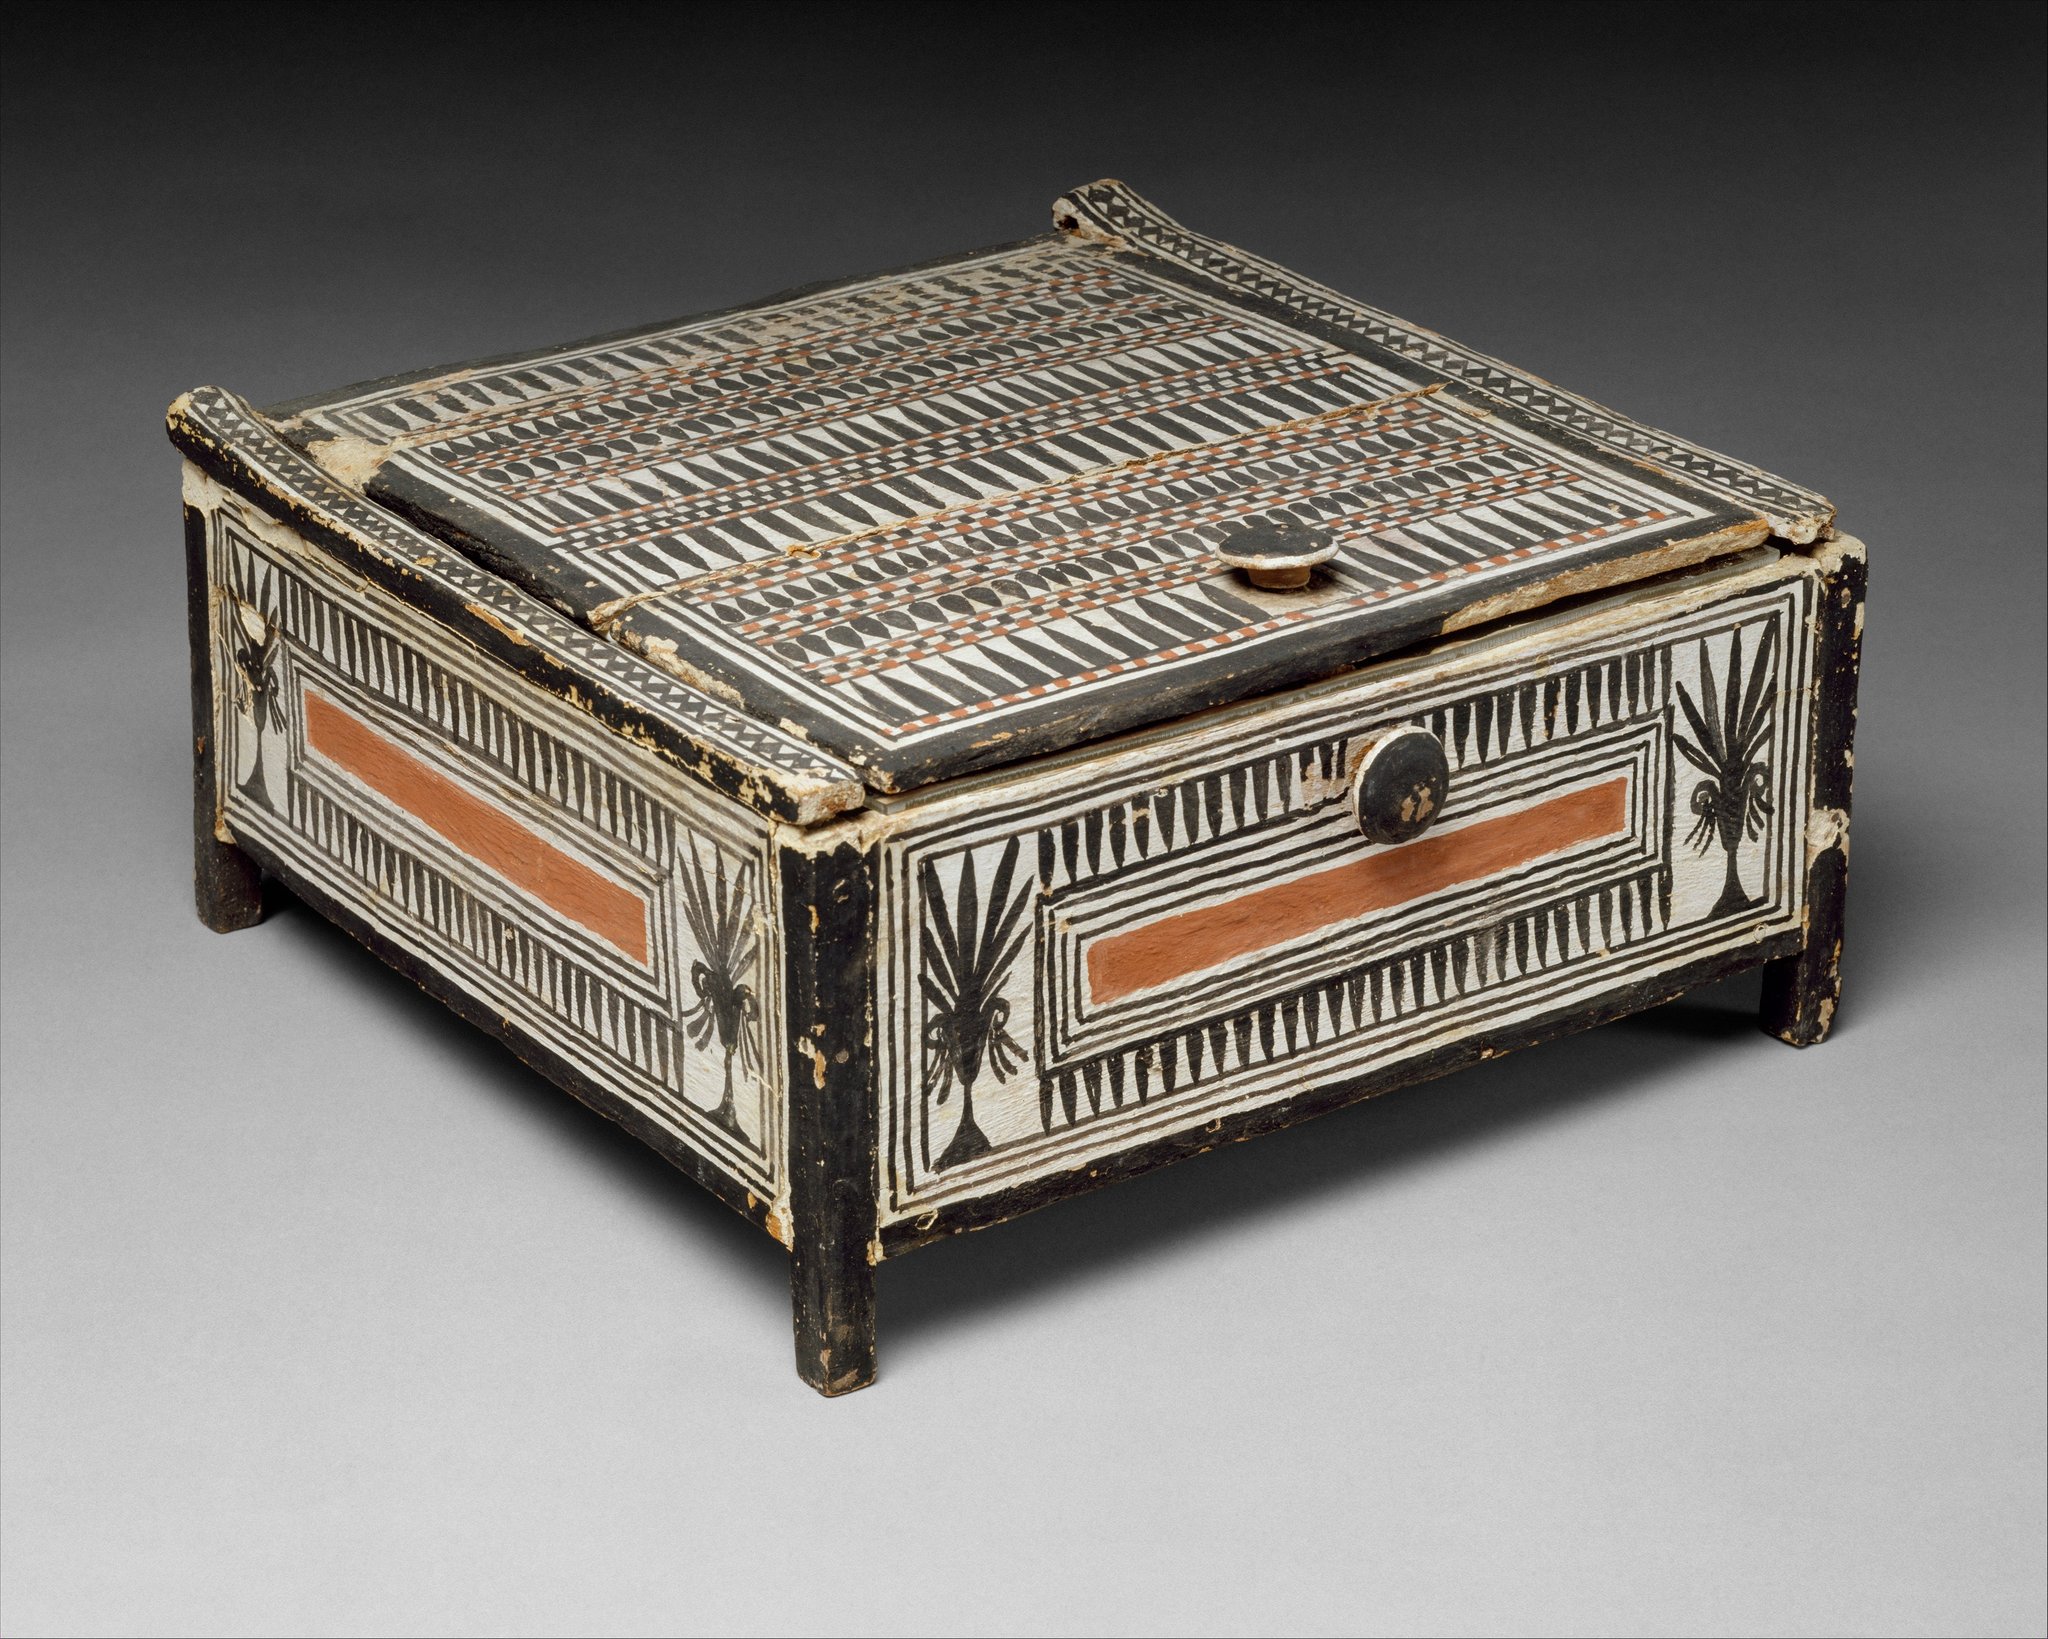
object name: cosmetic box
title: Cosmetic Box from the tomb of Sennedjem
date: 1279-1213 BCE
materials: wood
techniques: painting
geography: egypt